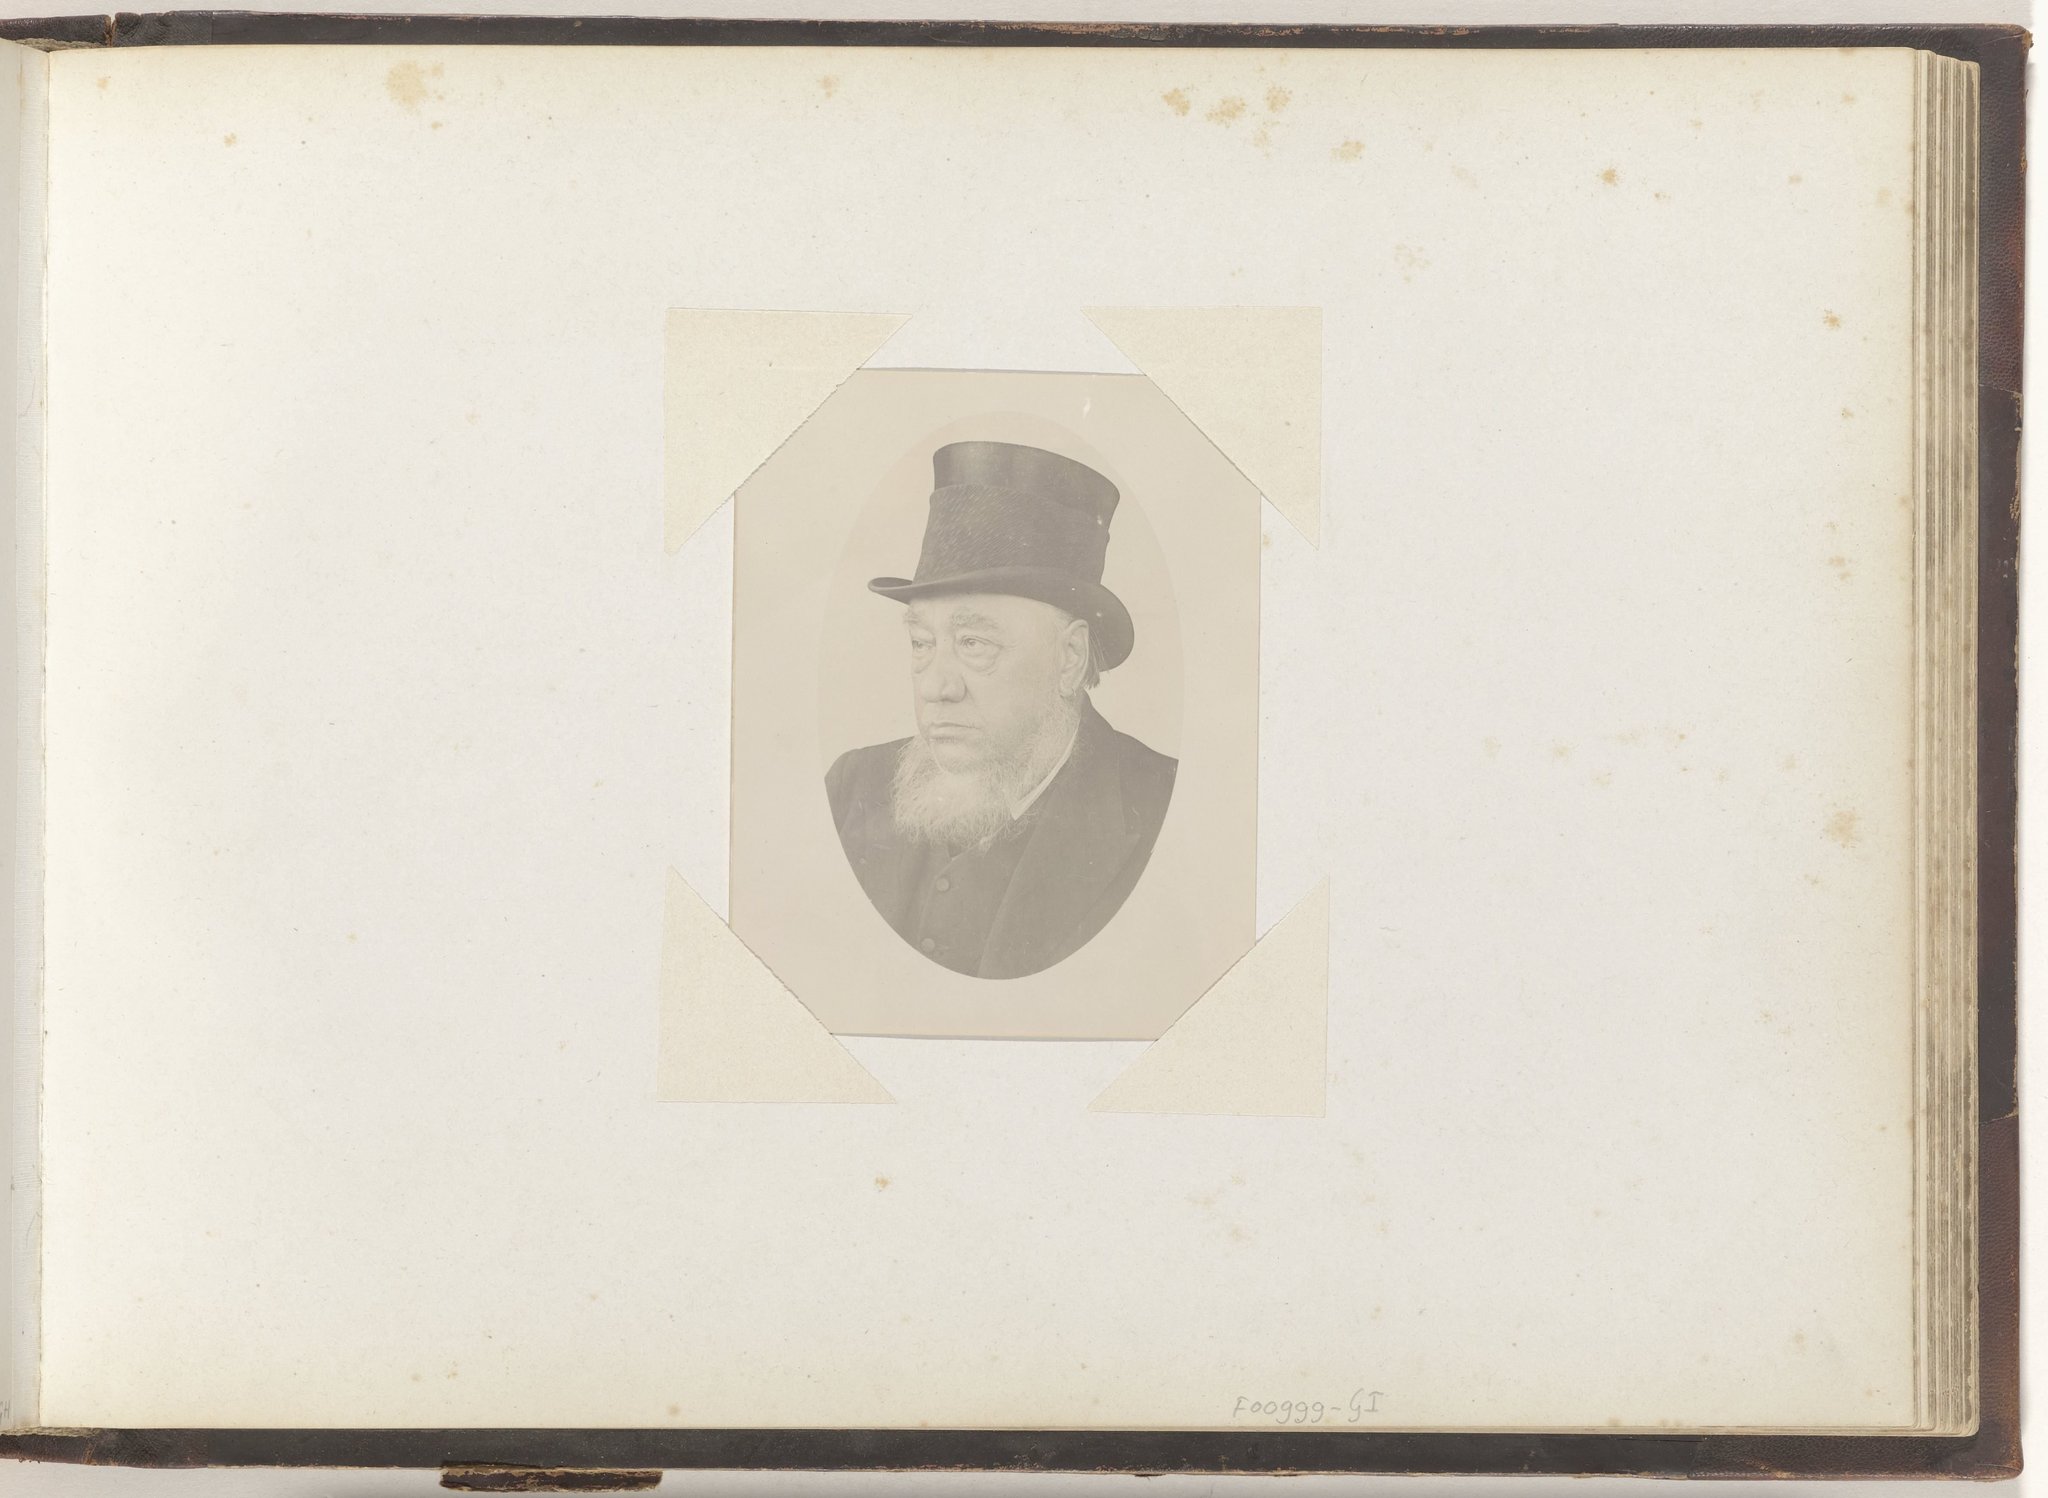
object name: photograph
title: Portret van Paul Kruger met hoge hoed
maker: Anonymous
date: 1899-1902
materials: paper, photographic support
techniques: gelatin silver print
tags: head-gear, president ~ head of republic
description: Onderdeel van Album met 191 foto's van een reis naar en door Zuid-Afrika.